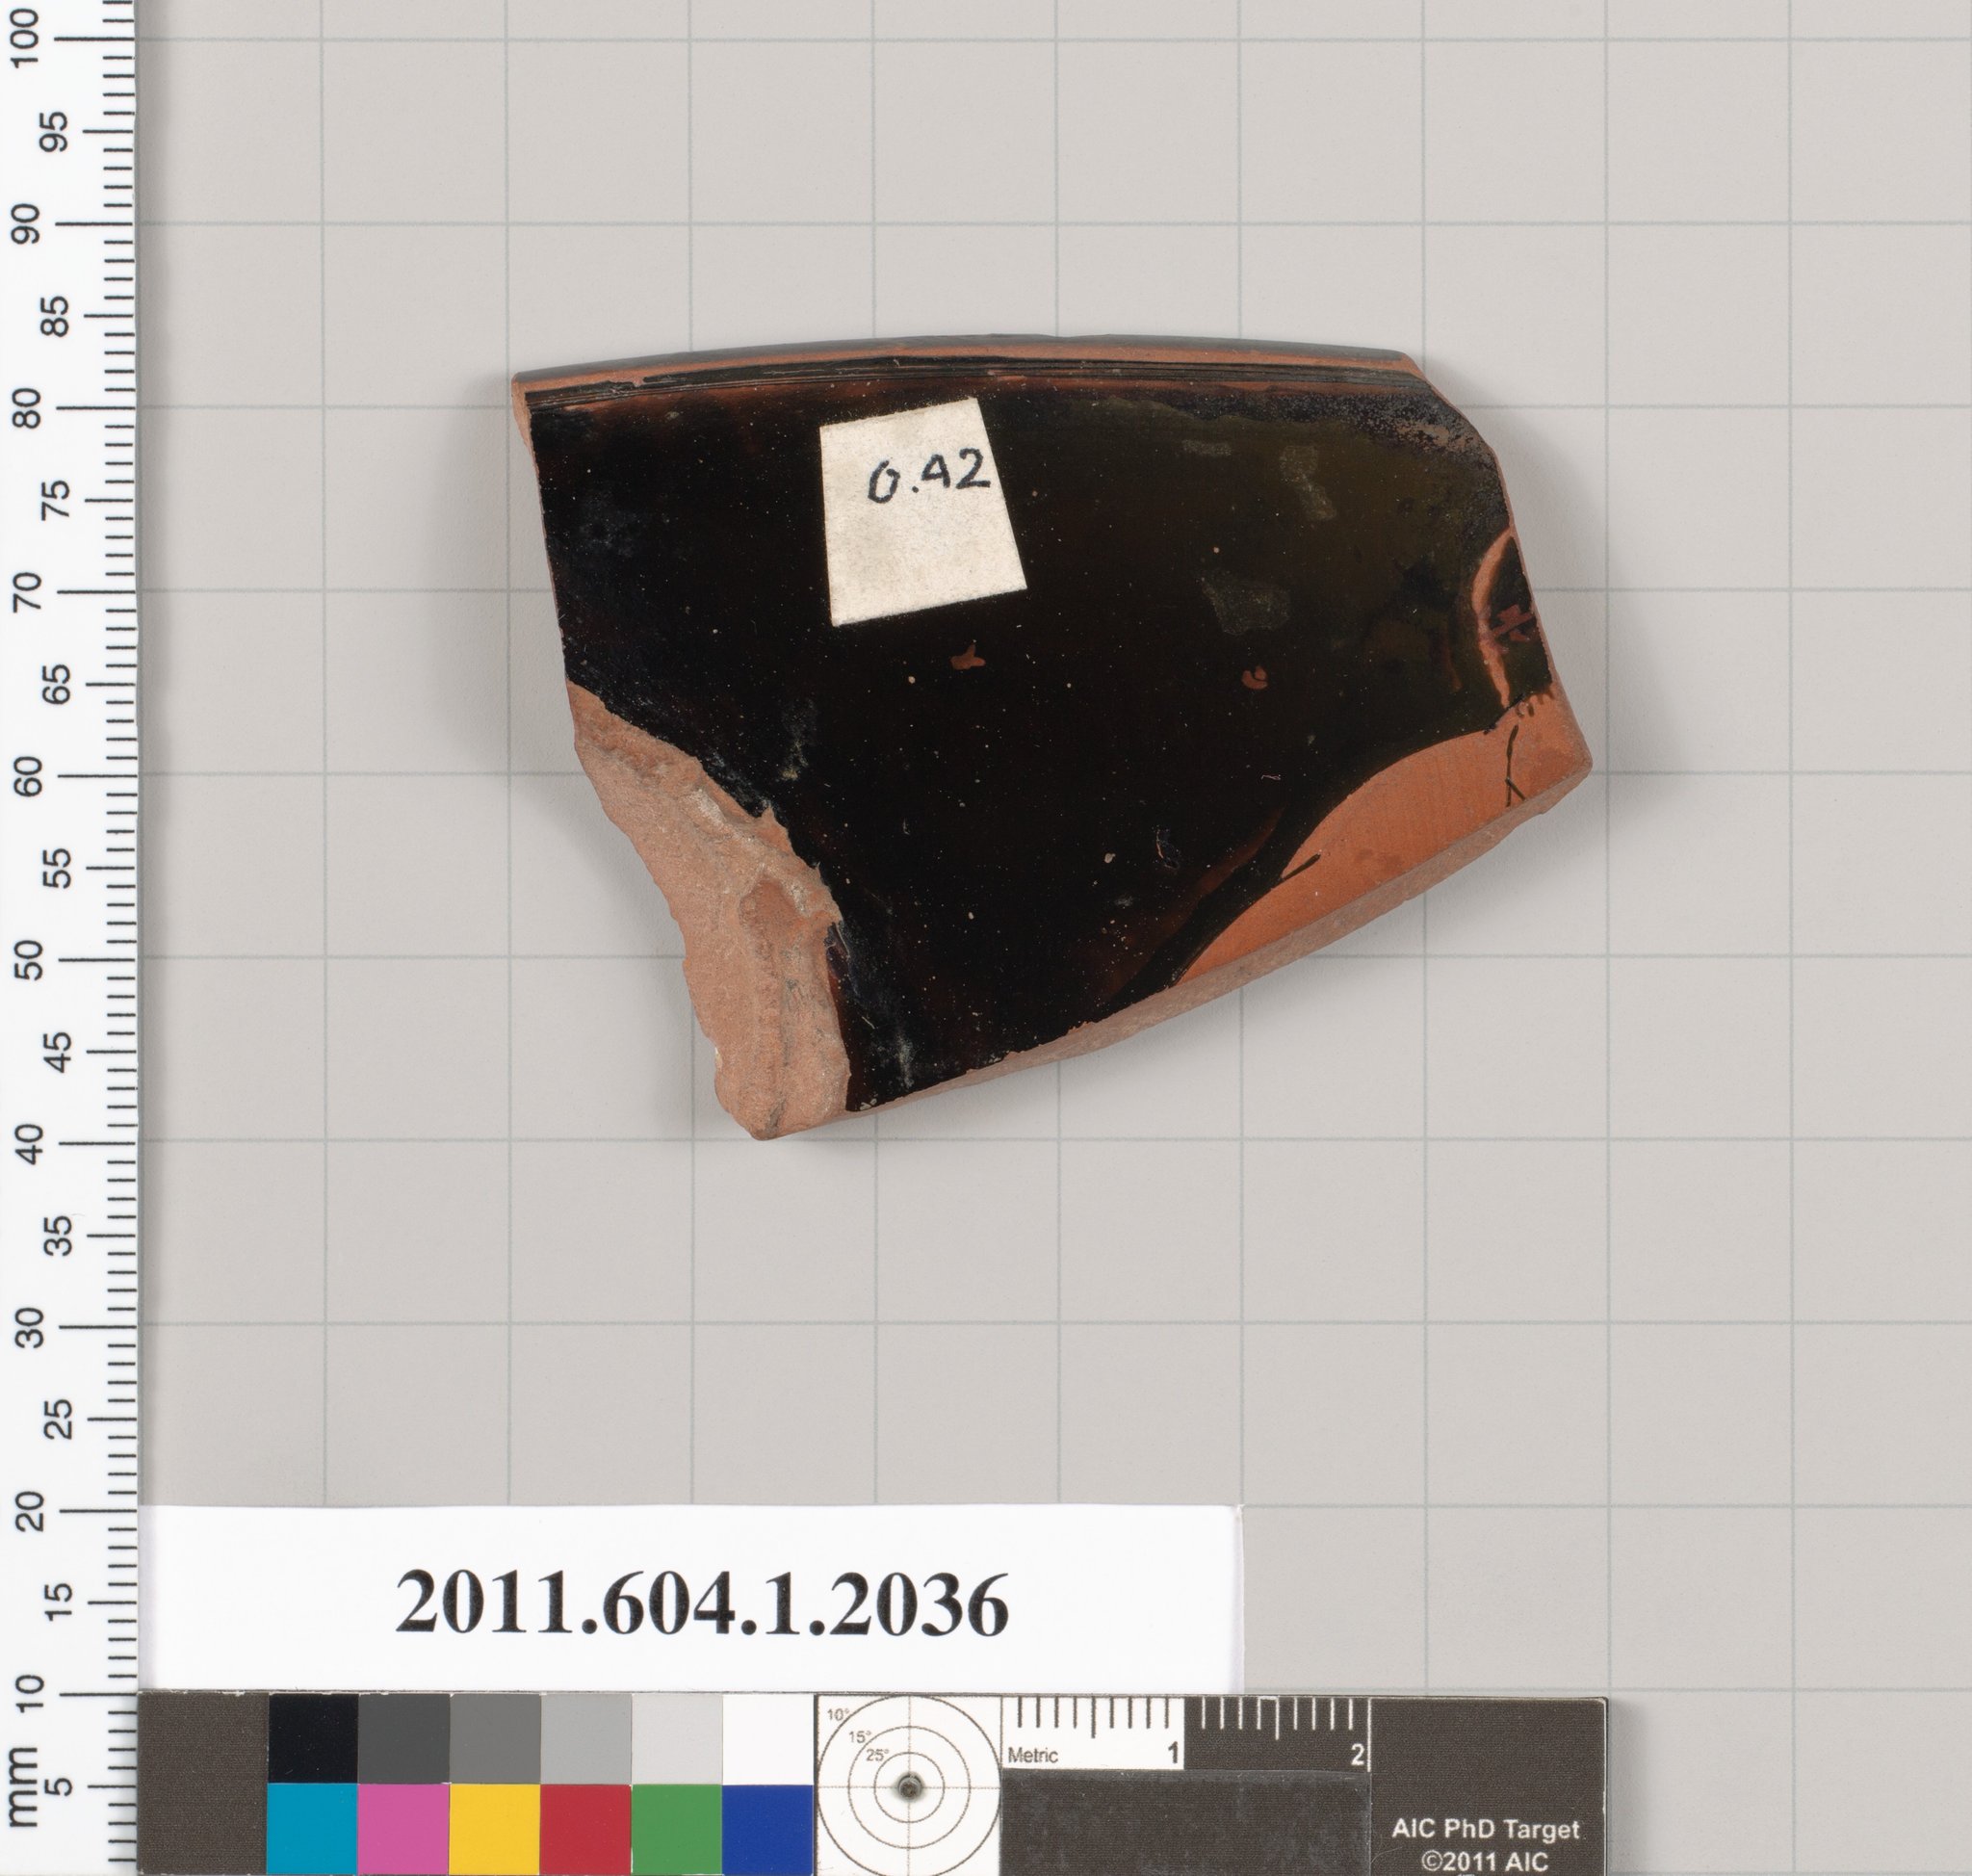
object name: kylix fragment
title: Terracotta rim fragment of a kylix (drinking cup)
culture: greek, attic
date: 475-451 BCE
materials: terracotta